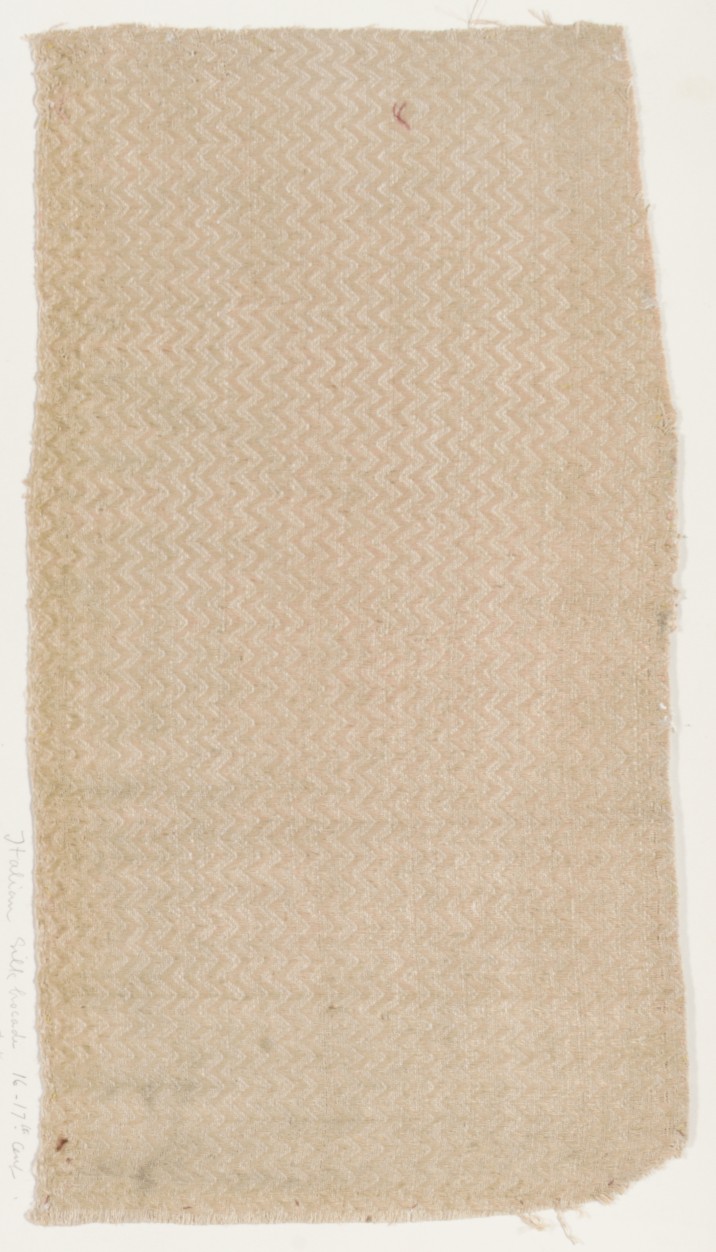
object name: fragment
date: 1501-1700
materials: silk